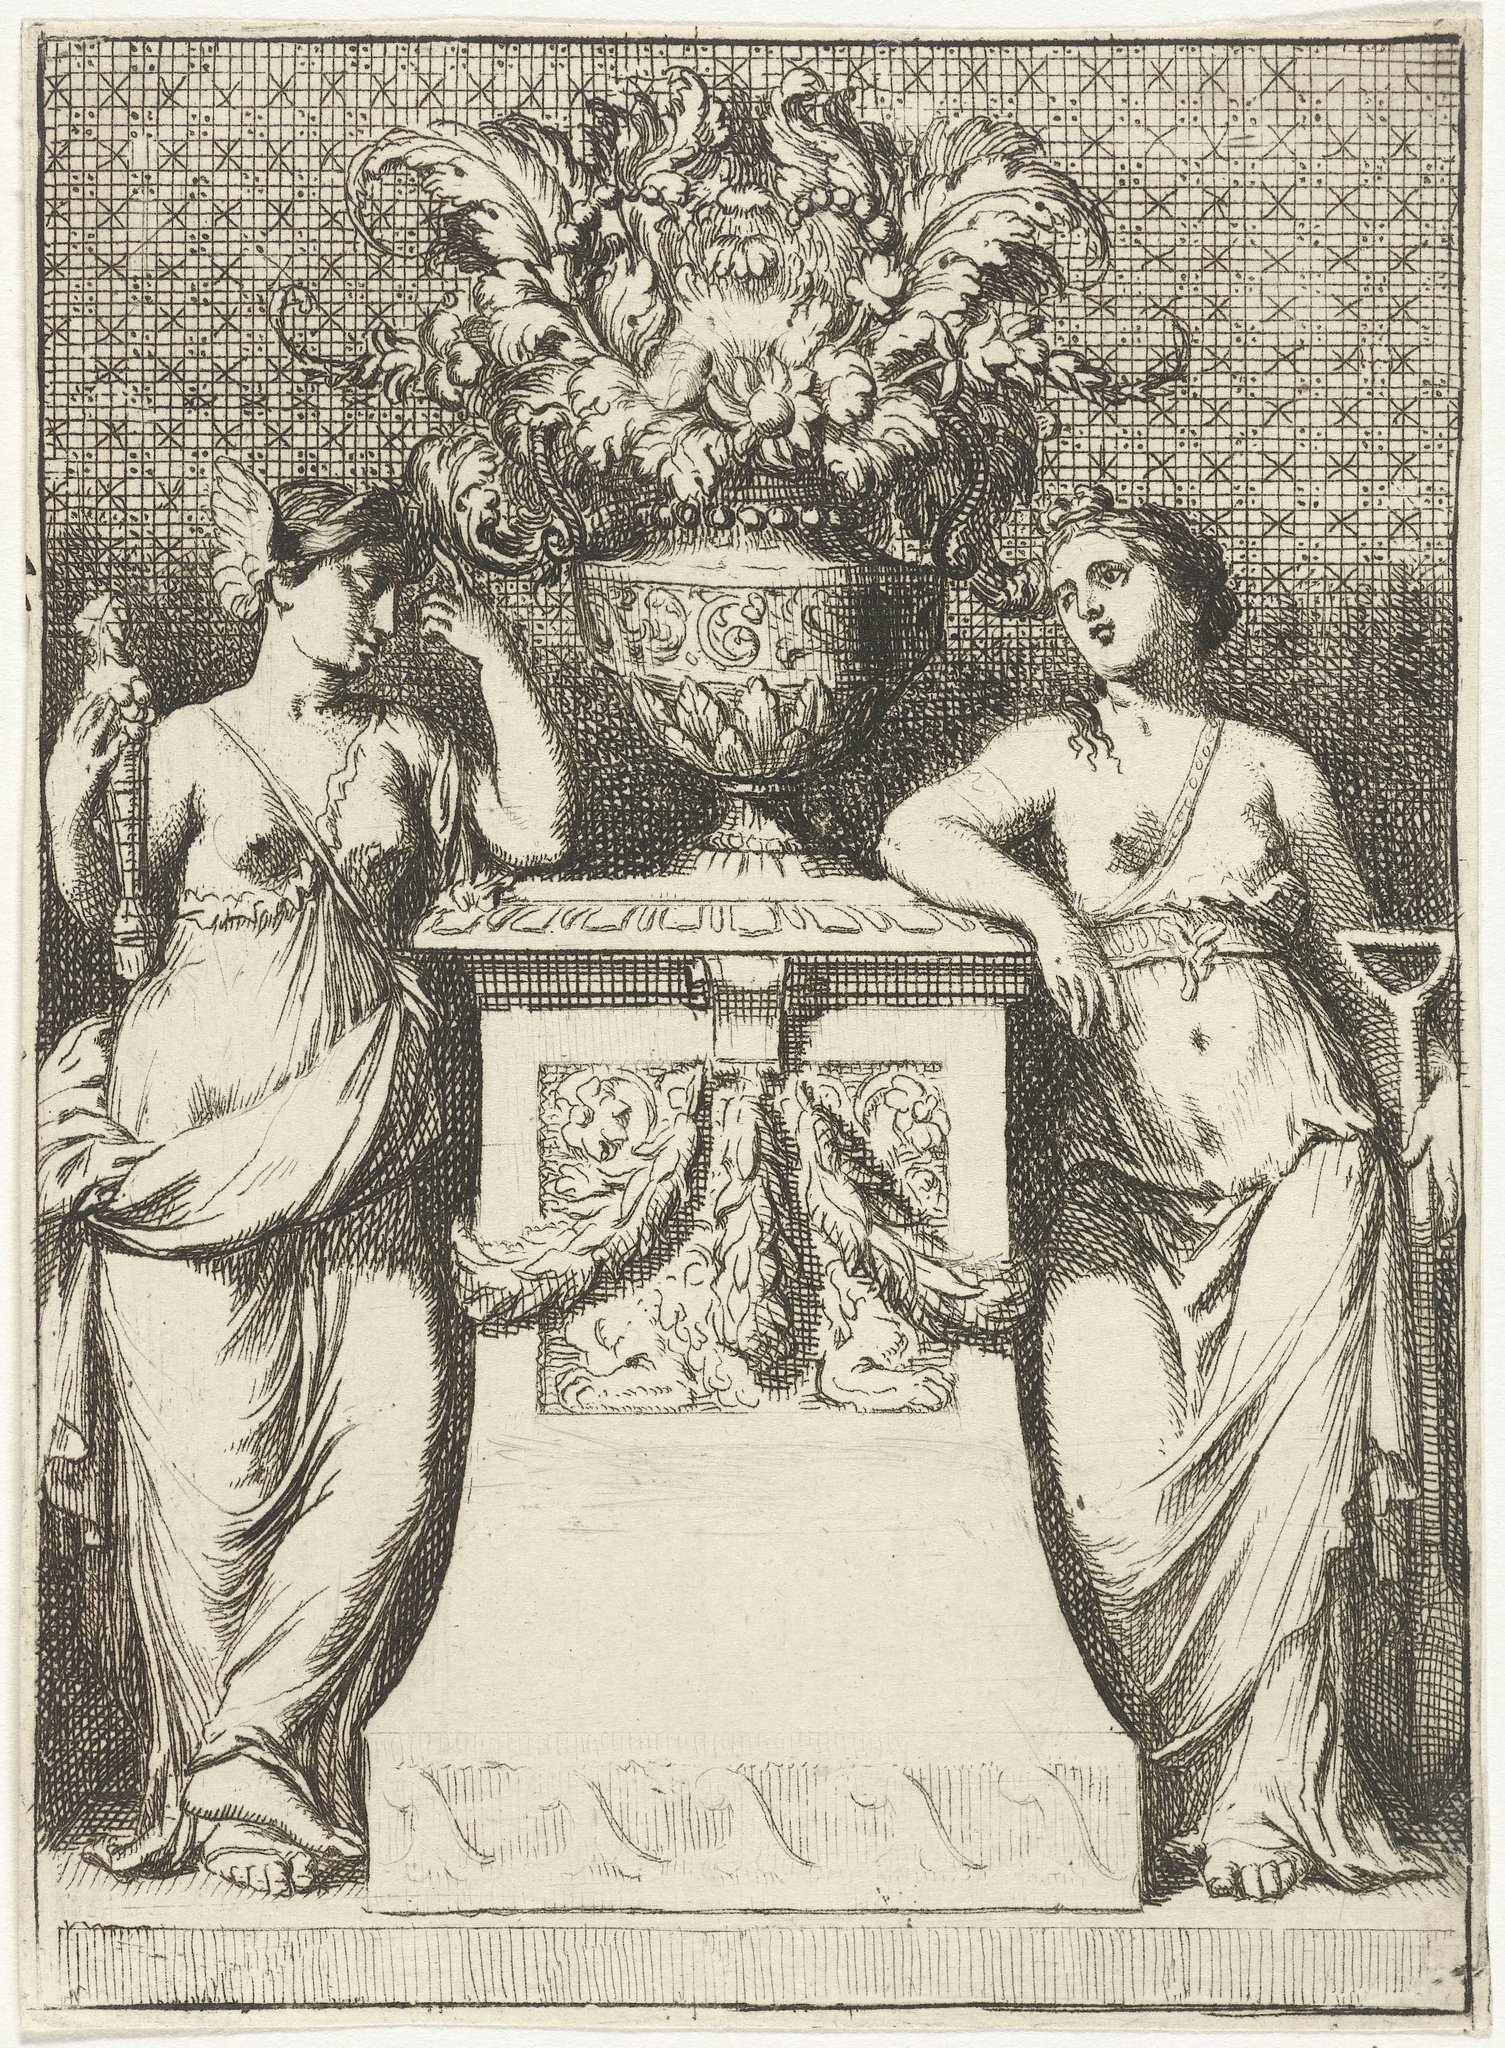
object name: print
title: Bloemenvaas geflankeerd door twee allegorische figuren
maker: gerard de lairesse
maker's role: draughtsman, painter, print maker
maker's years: 1641-1711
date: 1675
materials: paper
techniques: etching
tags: invention, inventiveness; 'inventione' (ripa) (+ personification), flowers in a vase, labour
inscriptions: collector's mark: Lugt 2228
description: Twee allegorische figuren staan links en rechts van een voetstuk waarop een bloemenvaas staat. De linker figuur met vleugeltjes langs haar hoofd en een klein beeld in haar handen stelt de personificatie van inventie voor. De rechter figuur draagt een schop en is mogelijk de personificatie van arbeid.